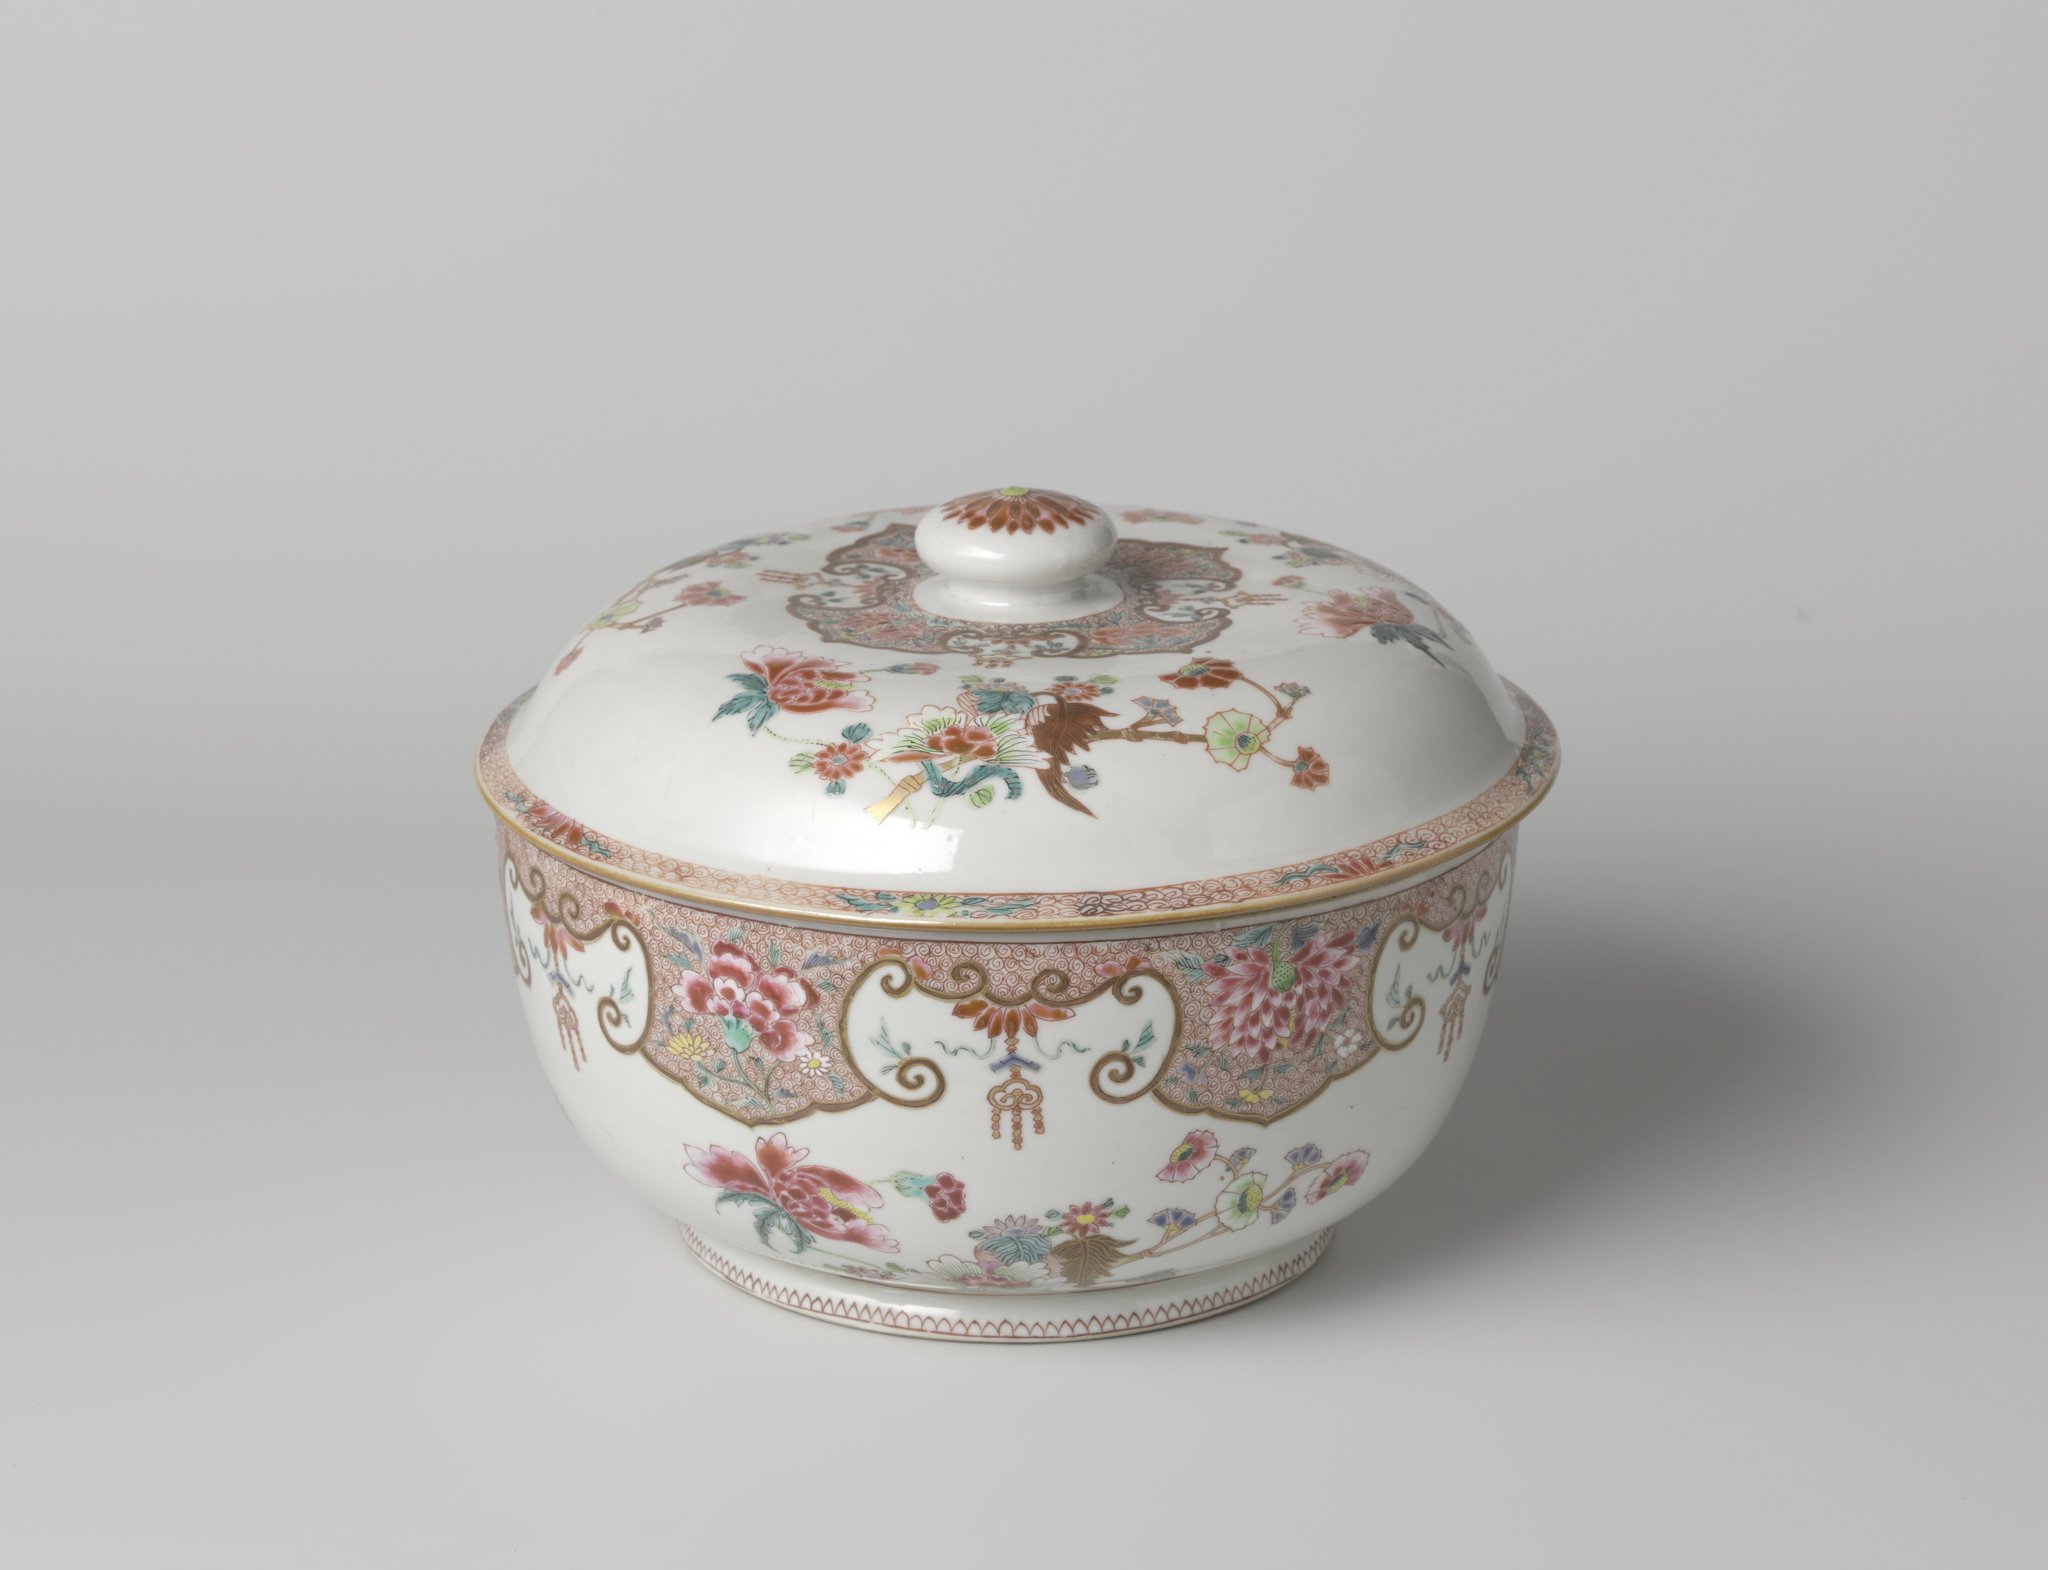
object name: tureen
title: Covered tureen with groups of flowers and ornamental border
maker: Anonymous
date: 1800-1899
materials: glaze, gold, paint, porcelain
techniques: firing, gilding, turning, vitrification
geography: china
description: Schaal met deksel van porselein beschilderd in famille rose met lambrequins en bloemen.